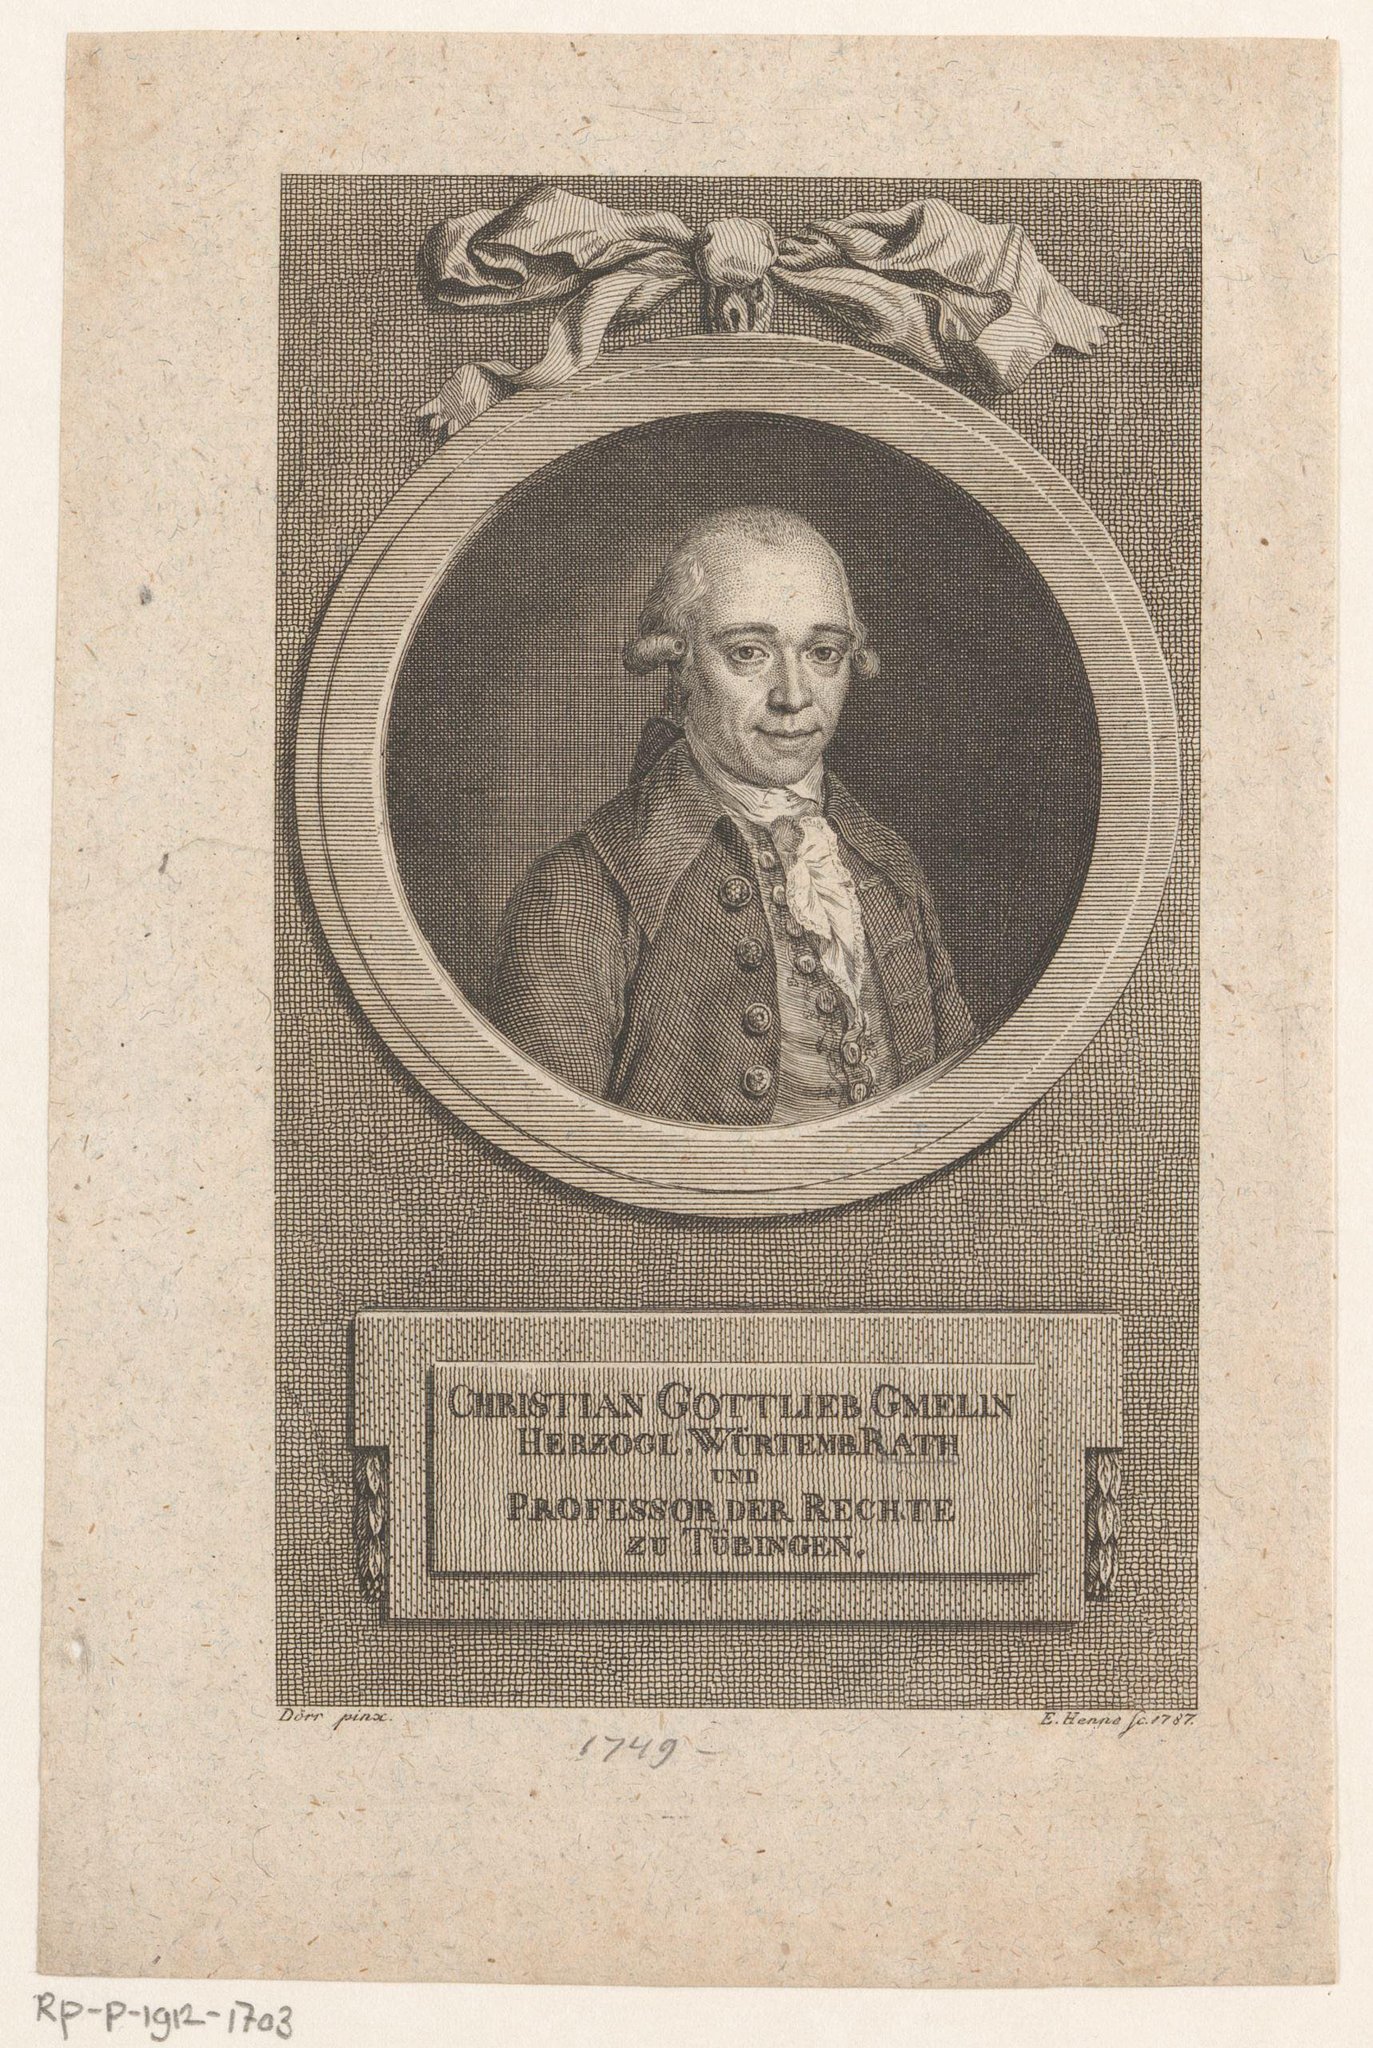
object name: print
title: Portret van Christian Gottlieb von Gmelin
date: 1769-1828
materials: paper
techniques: engraving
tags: ornament ~ medallion, historical persons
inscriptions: collector's mark: Lugt 2228